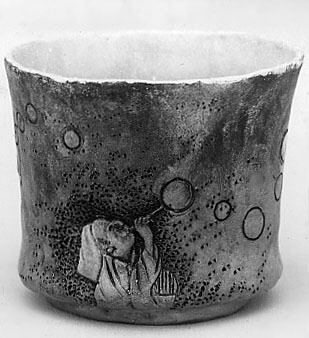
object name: cup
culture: japanese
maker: koren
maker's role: artist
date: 1801-1833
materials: pottery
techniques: relief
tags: men,bubbles